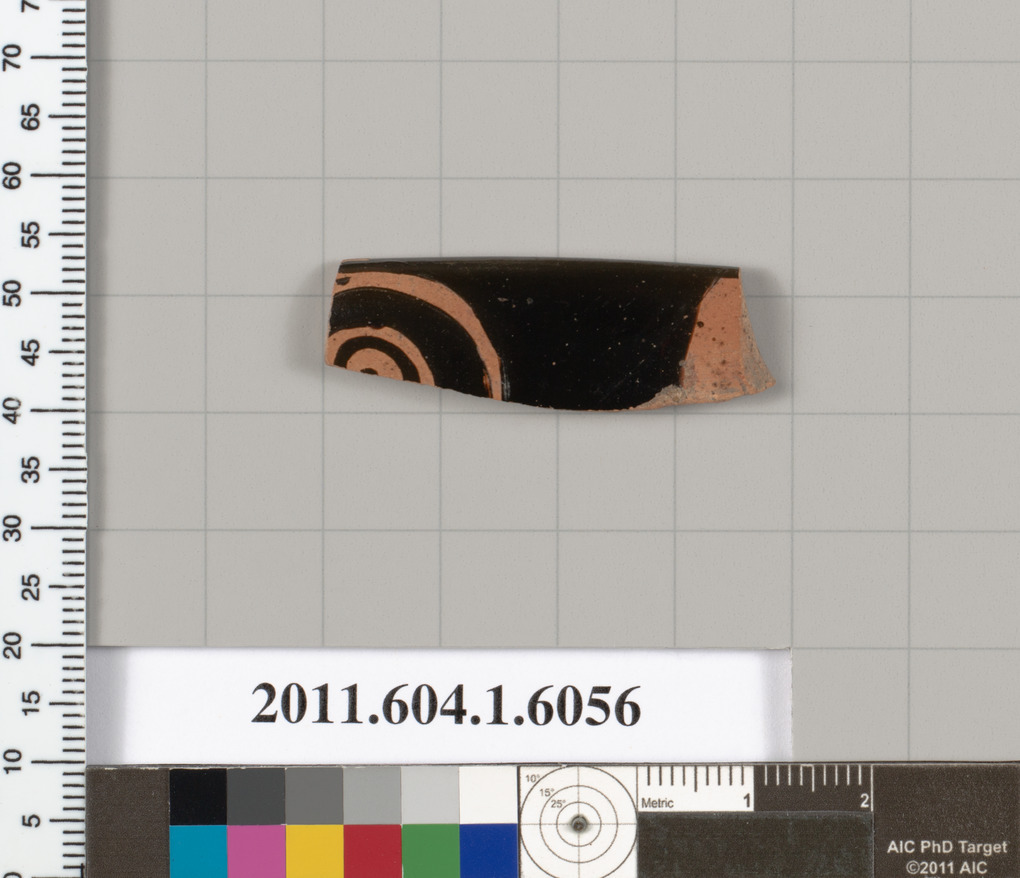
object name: kylix fragment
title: Terracotta fragment of a kylix (drinking cup)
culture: greek, attic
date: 510-500 BCE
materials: terracotta